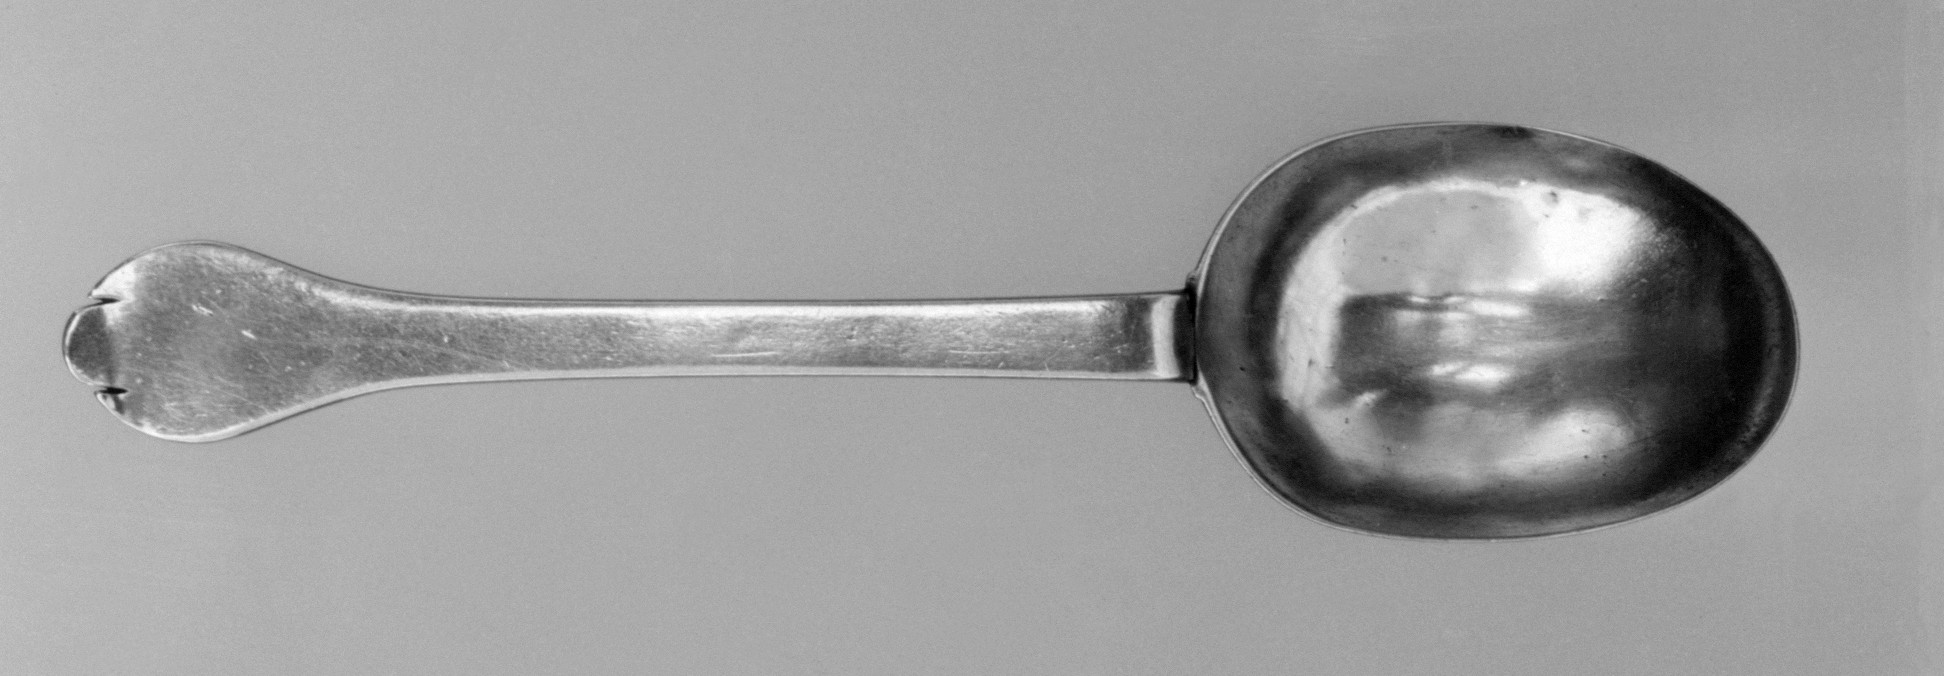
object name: spoon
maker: thomas issod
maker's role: maker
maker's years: 1683-1697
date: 1695-1696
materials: silver